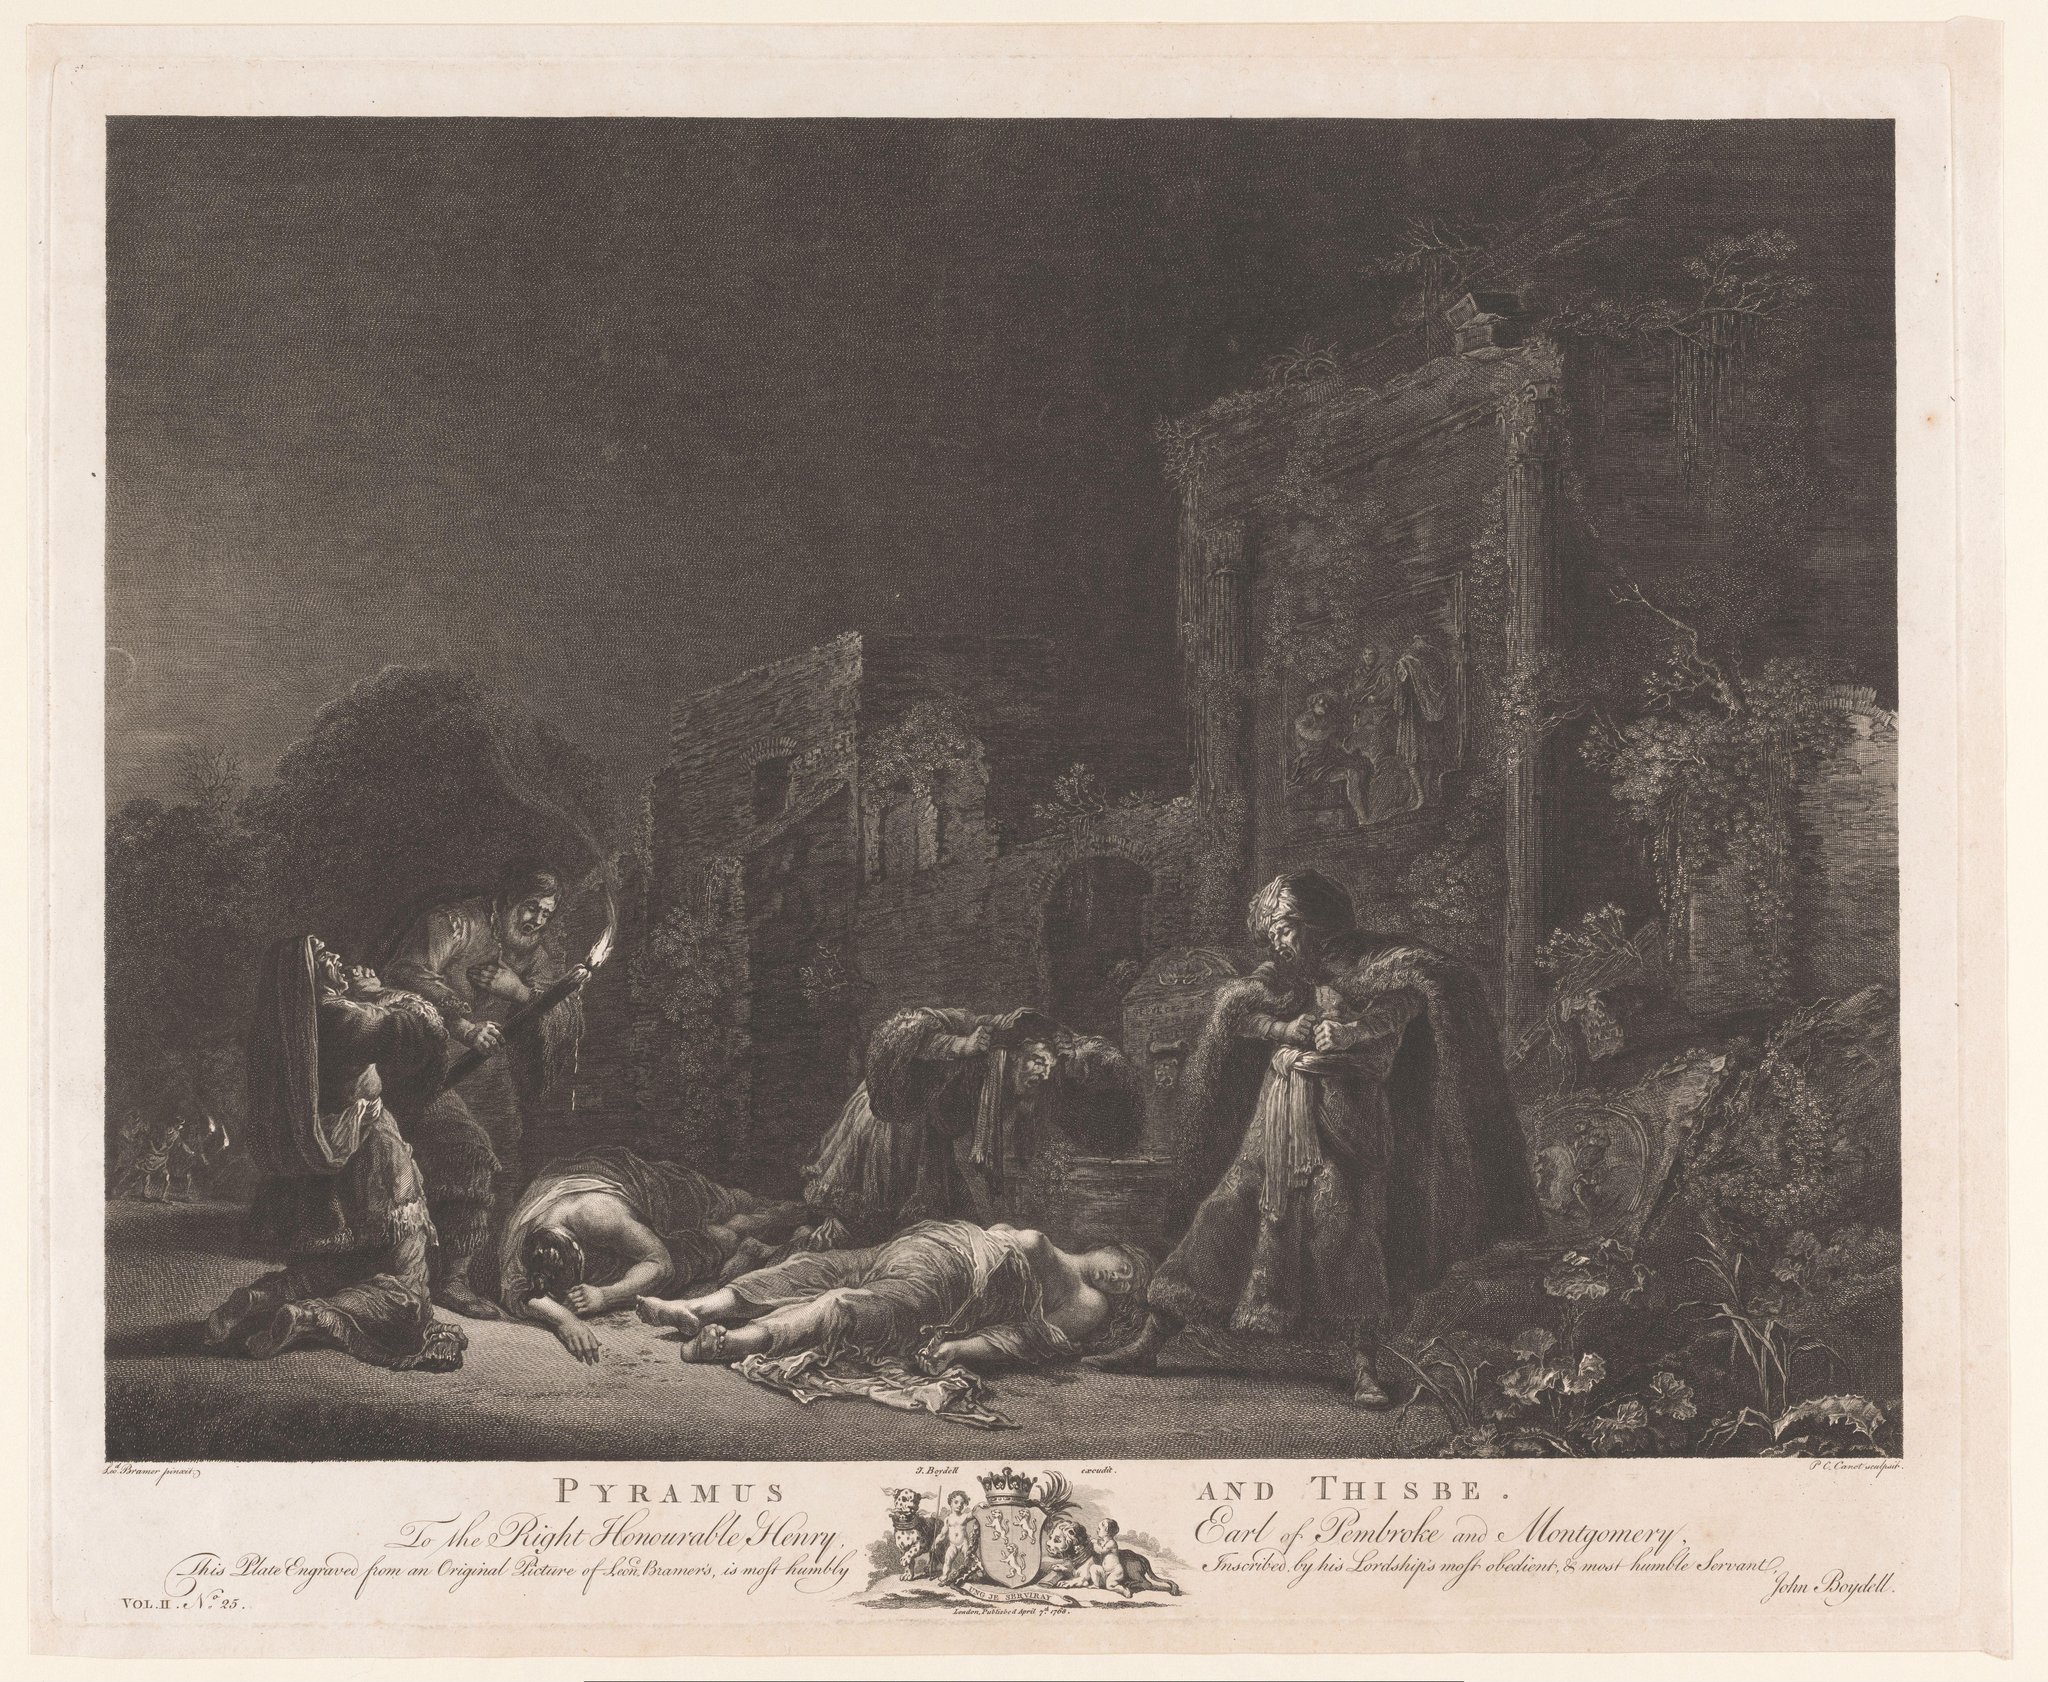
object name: print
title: Pyramus and Thisbe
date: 1768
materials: paper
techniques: engraving, etching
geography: london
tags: thisbe kills herself with pyramus' sword (the scene may be represented near a fountain)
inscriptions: collector's mark: Lugt 2228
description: Prent hoort bij de serie 'The Most Capital Paintings in England', tussen 1763 en 1786 gepubliceerd door John Boydell.